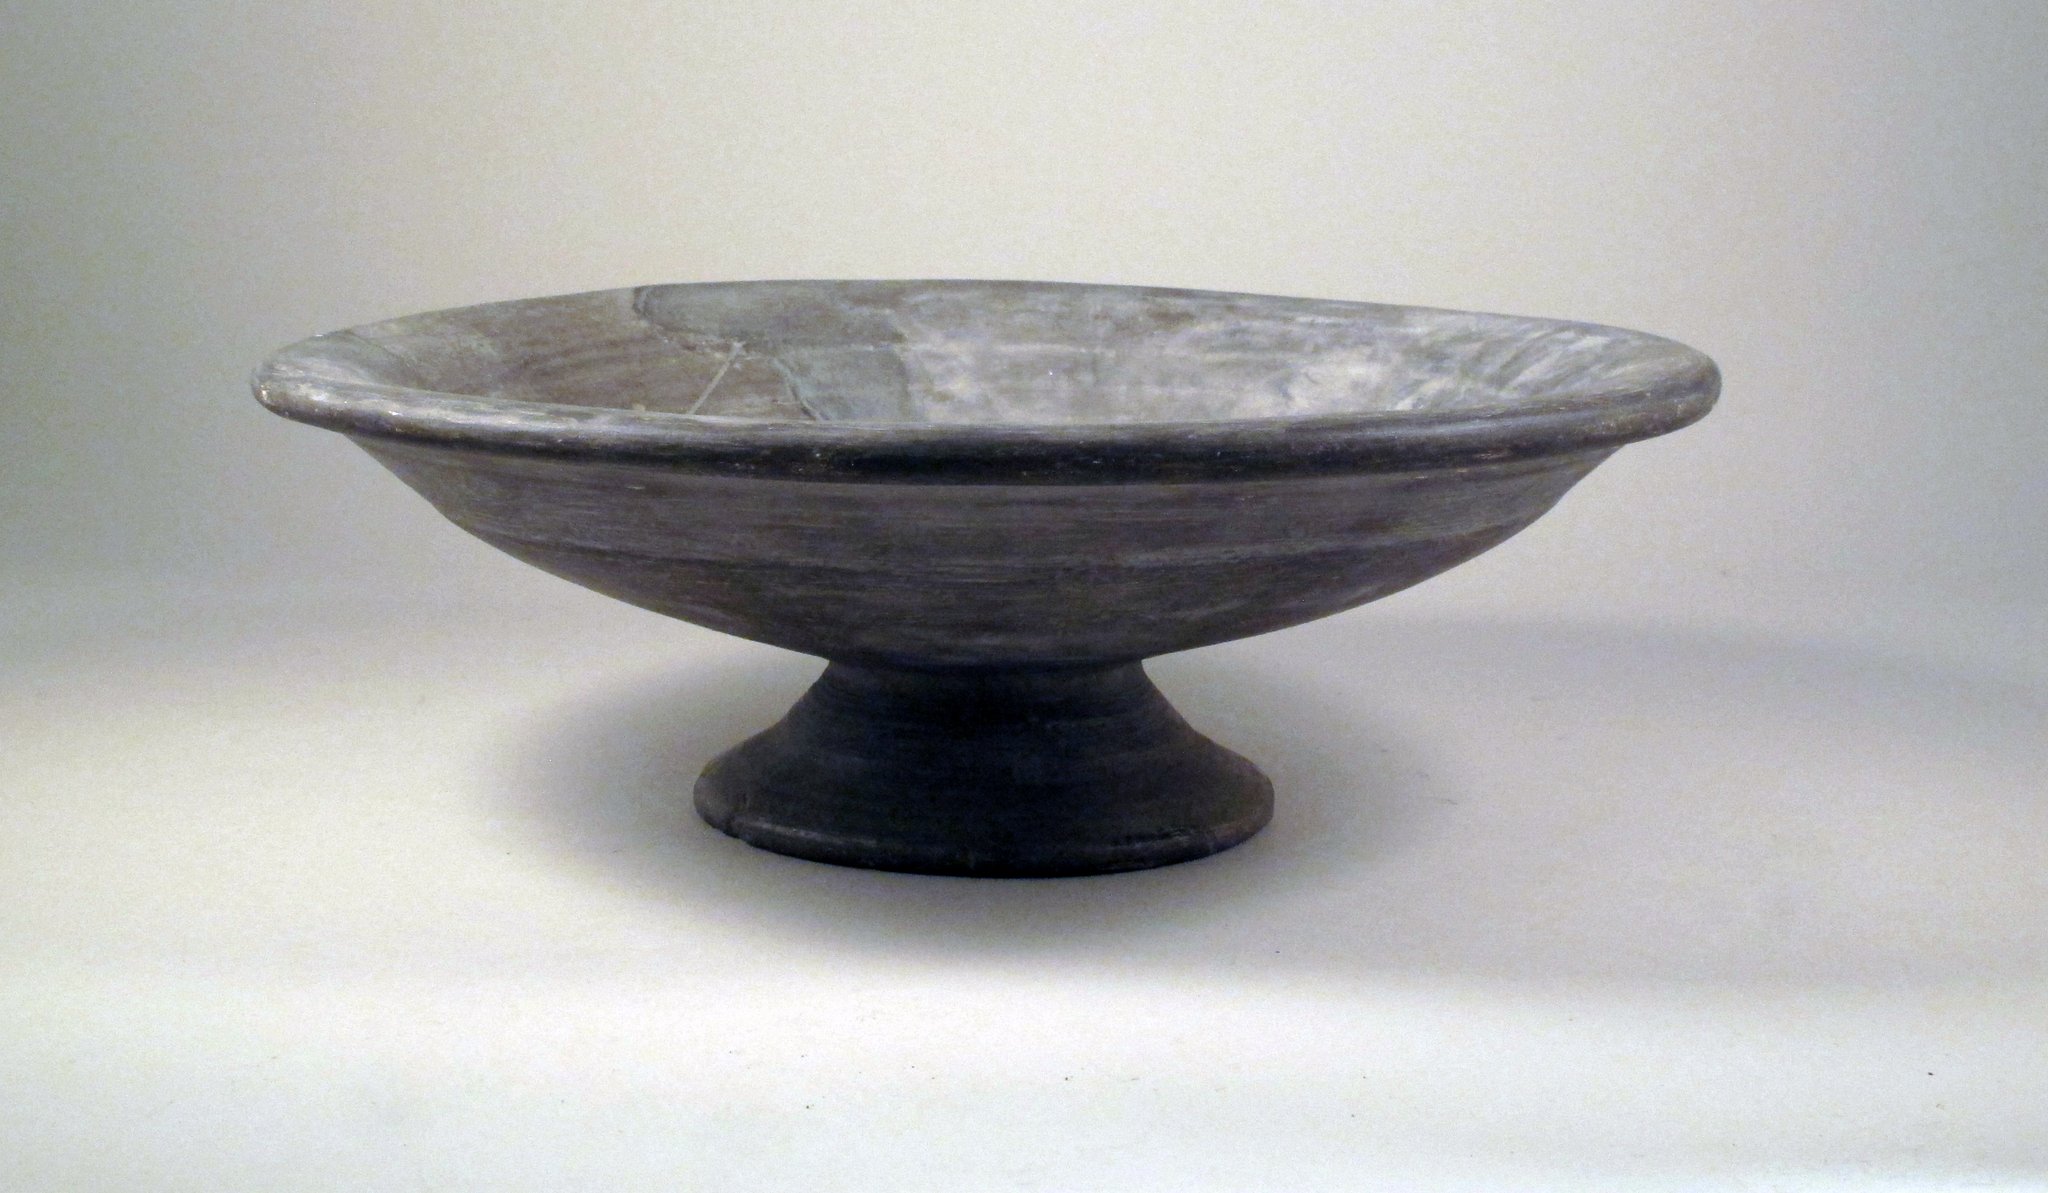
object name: bowl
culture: greek or lydian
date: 900-30 BCE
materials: terracotta